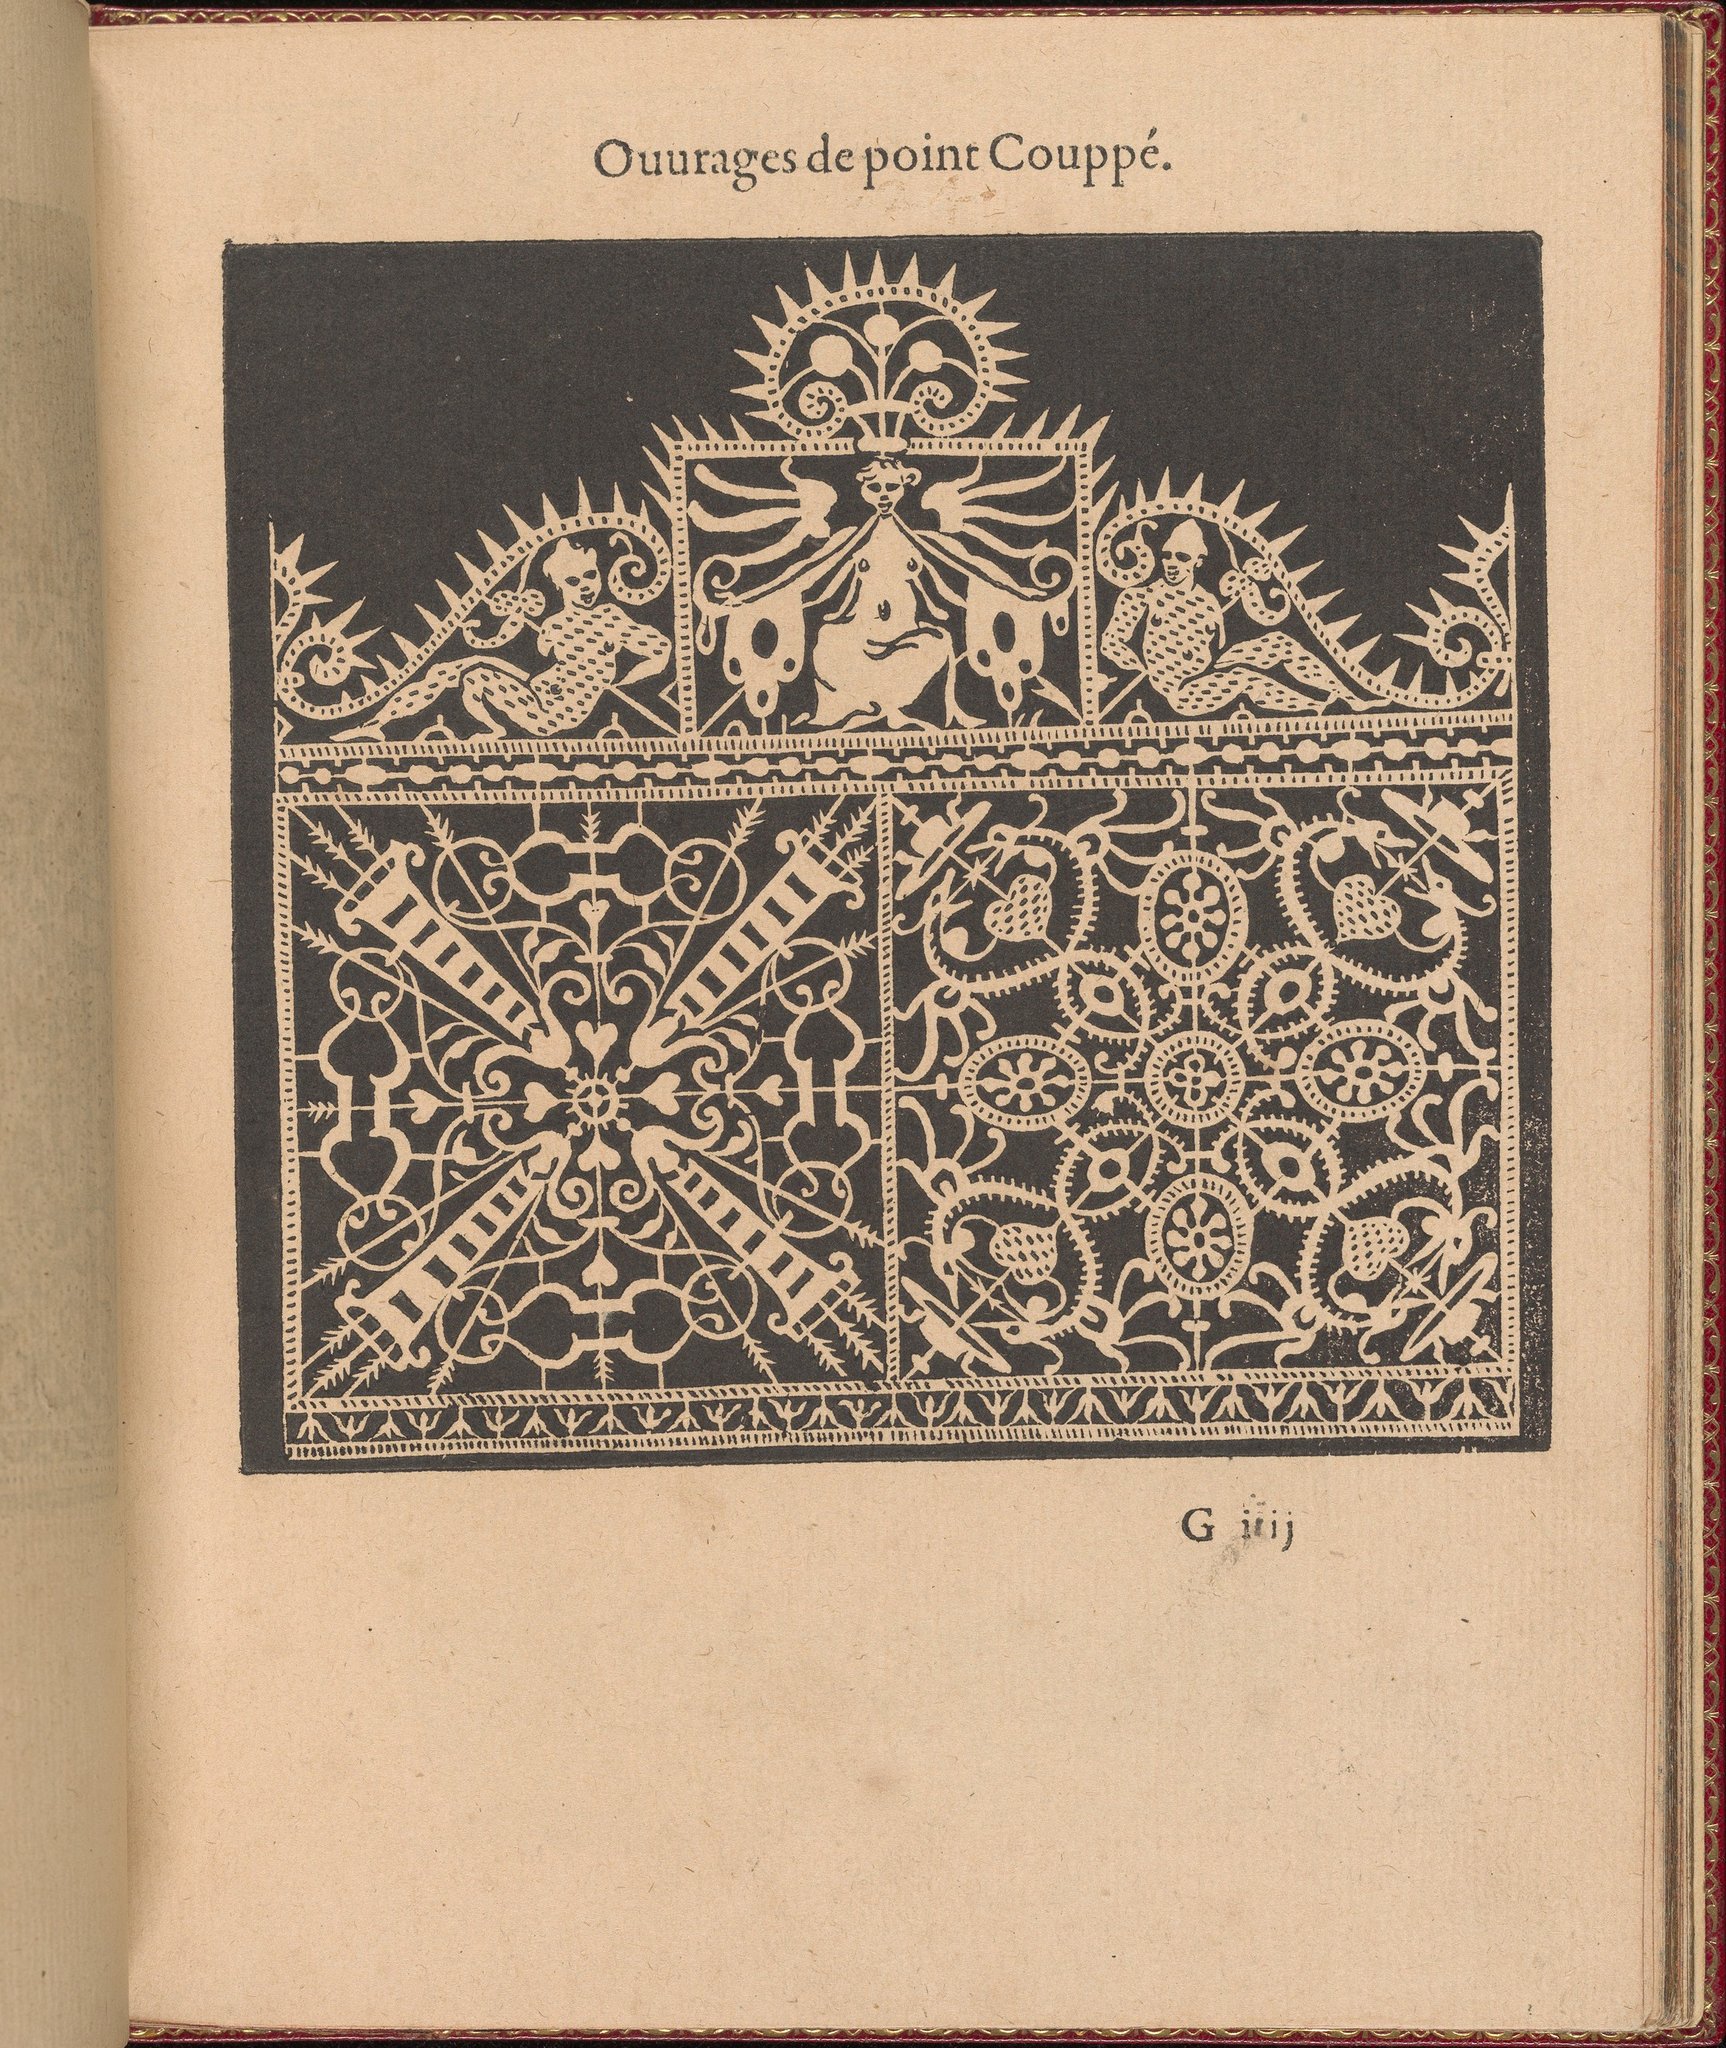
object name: book print ornament architecture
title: Les Singuliers et Nouveaux Portraicts... page 28 (recto)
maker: federico de vinciolo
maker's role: designer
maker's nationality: italian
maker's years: 1582-1599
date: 1588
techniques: woodcut